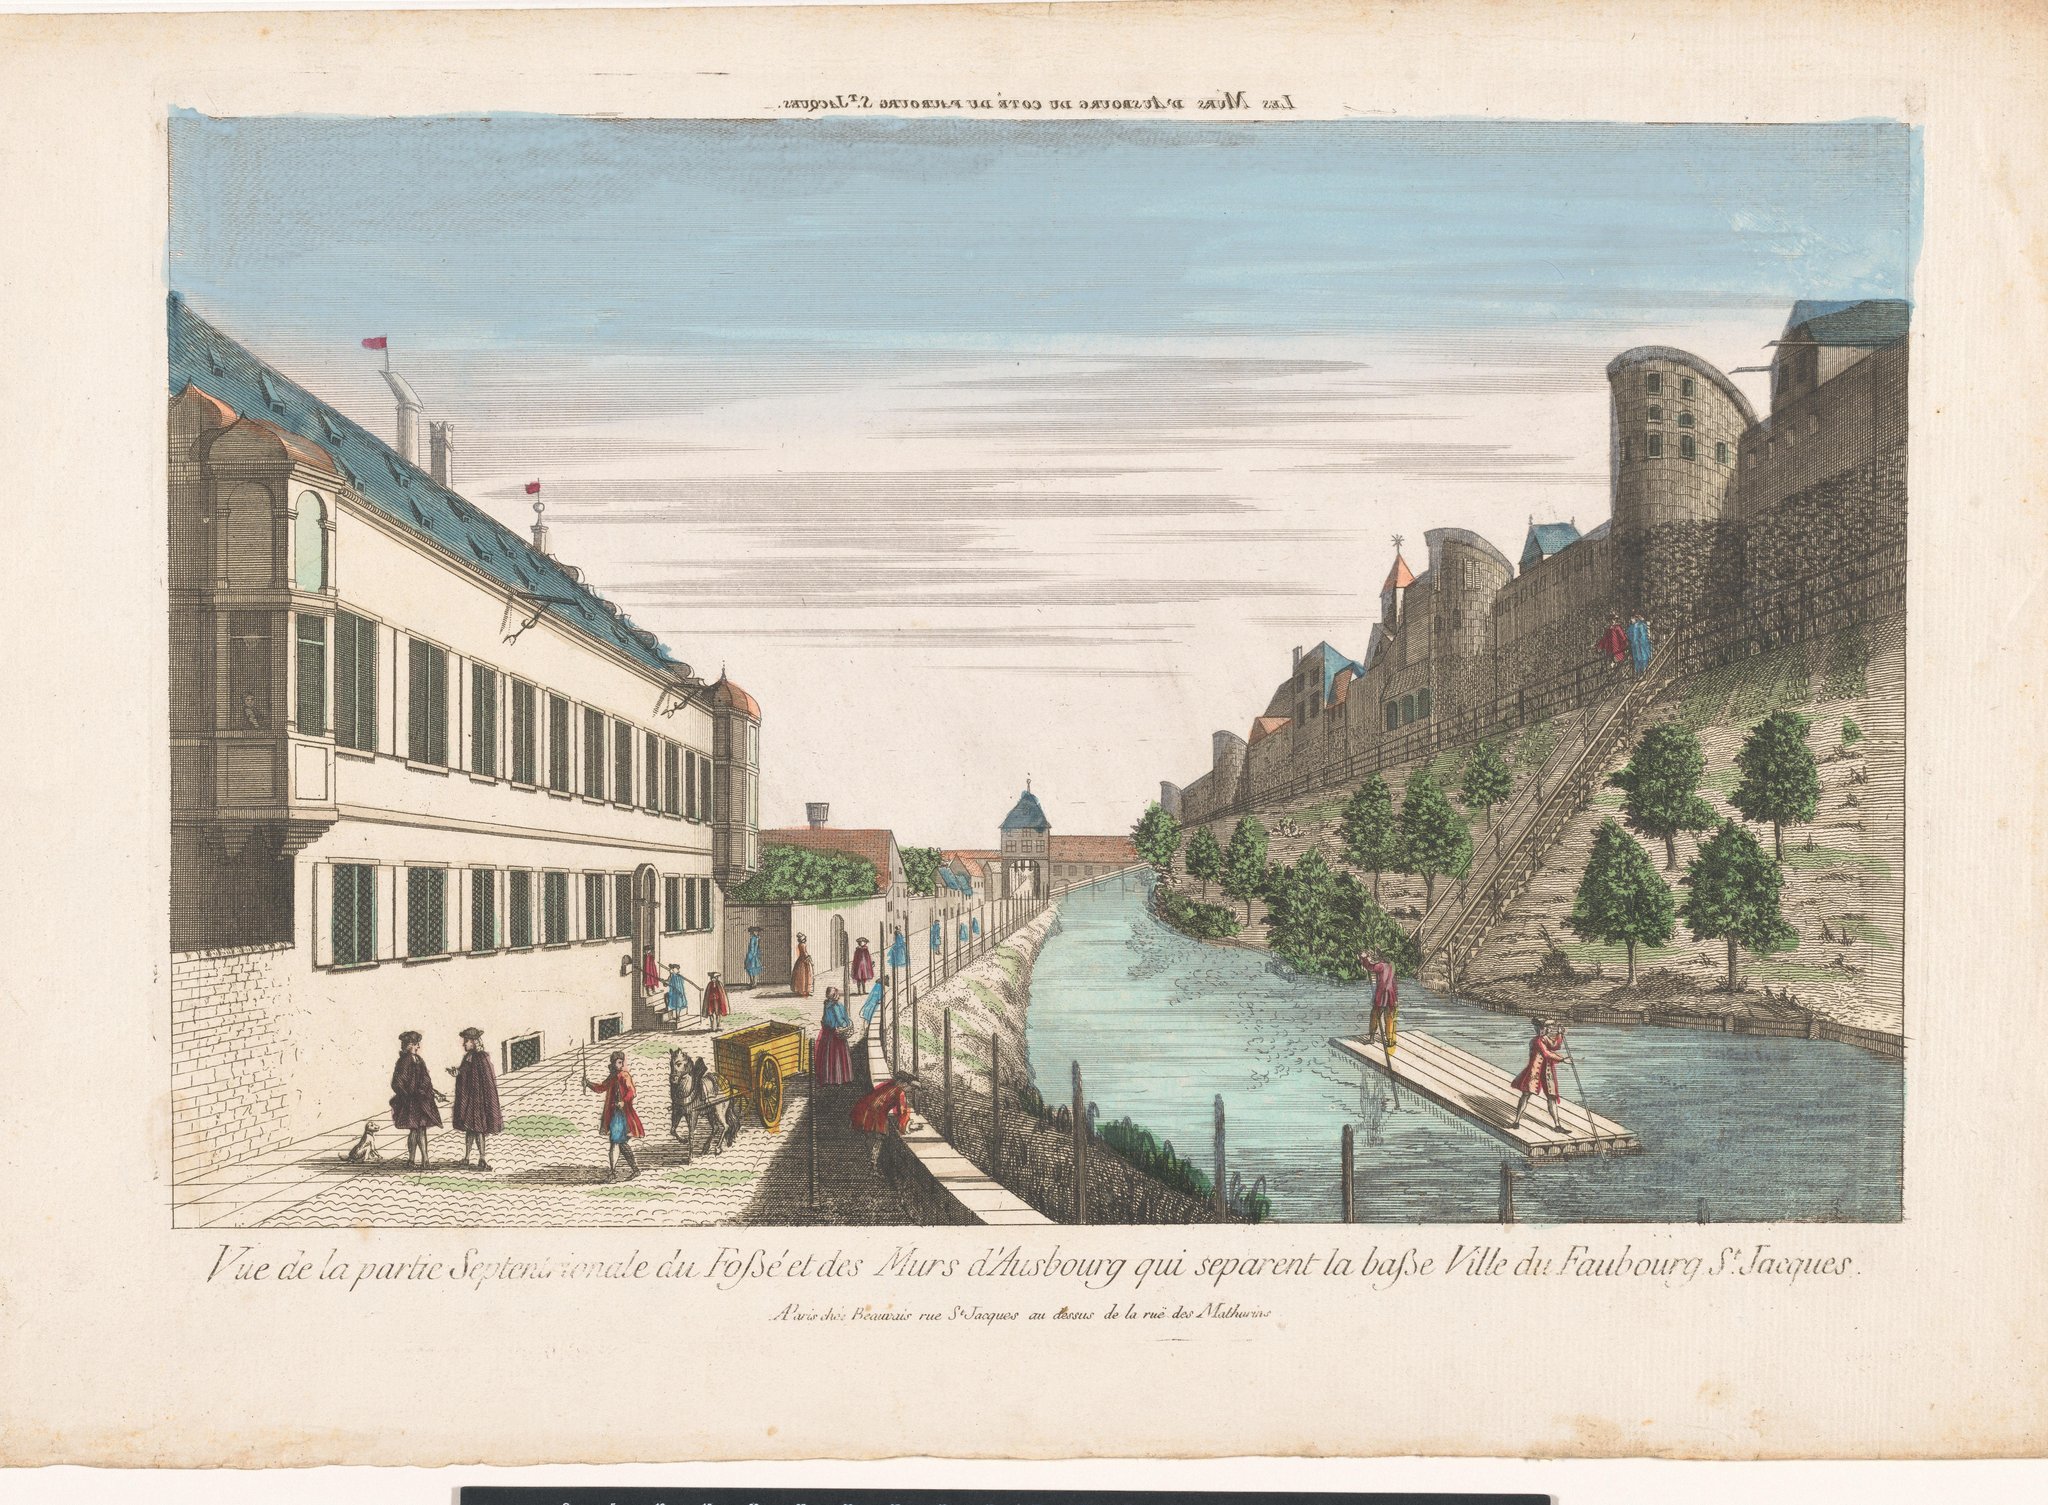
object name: print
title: Gezicht op het noordelijke deel van de stadsmuur en een buitenwijk te Augsburg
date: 1700-1799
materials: paper, watercolor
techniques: brush, etching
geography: france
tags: canal, outskirts of city, city-gate, city-walls (+ city(-scape) with figures, staffage), augsburg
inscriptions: watermark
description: Op de gracht rondom de stadsmuur vaart een vlot met twee figuren. Op de achtergrond staat een stadspoort.